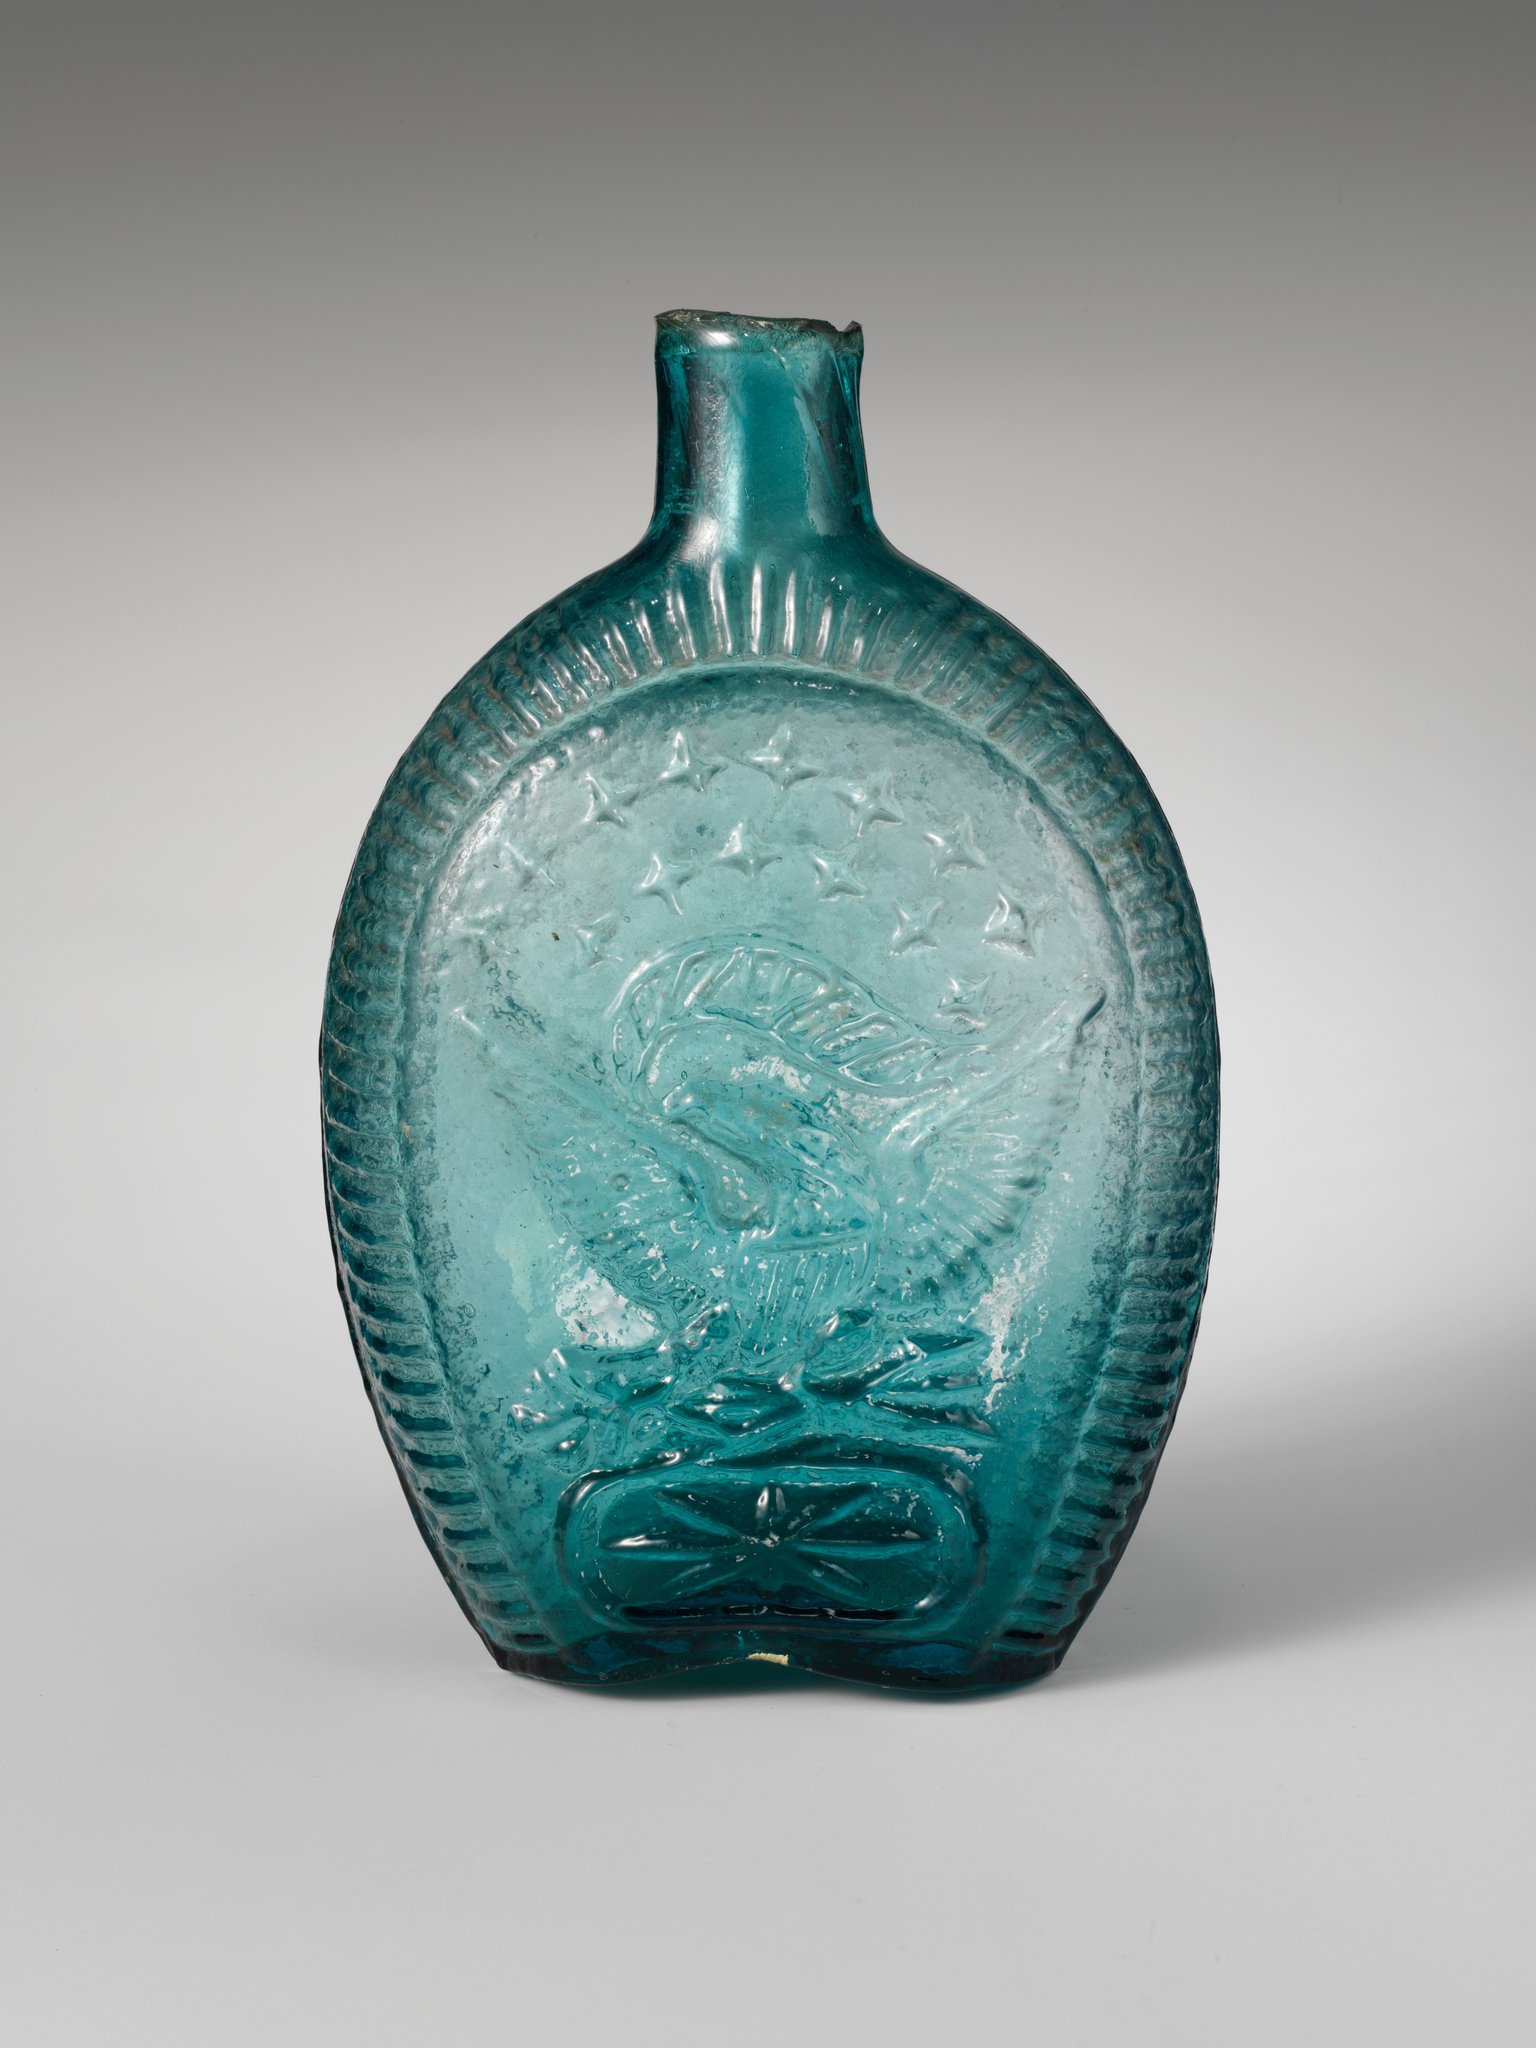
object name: flask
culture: american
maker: kentucky glass works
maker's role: maker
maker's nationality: american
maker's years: 1850-1855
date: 1840-1860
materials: gemstone, glass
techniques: glassblowing, molding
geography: united states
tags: eagles